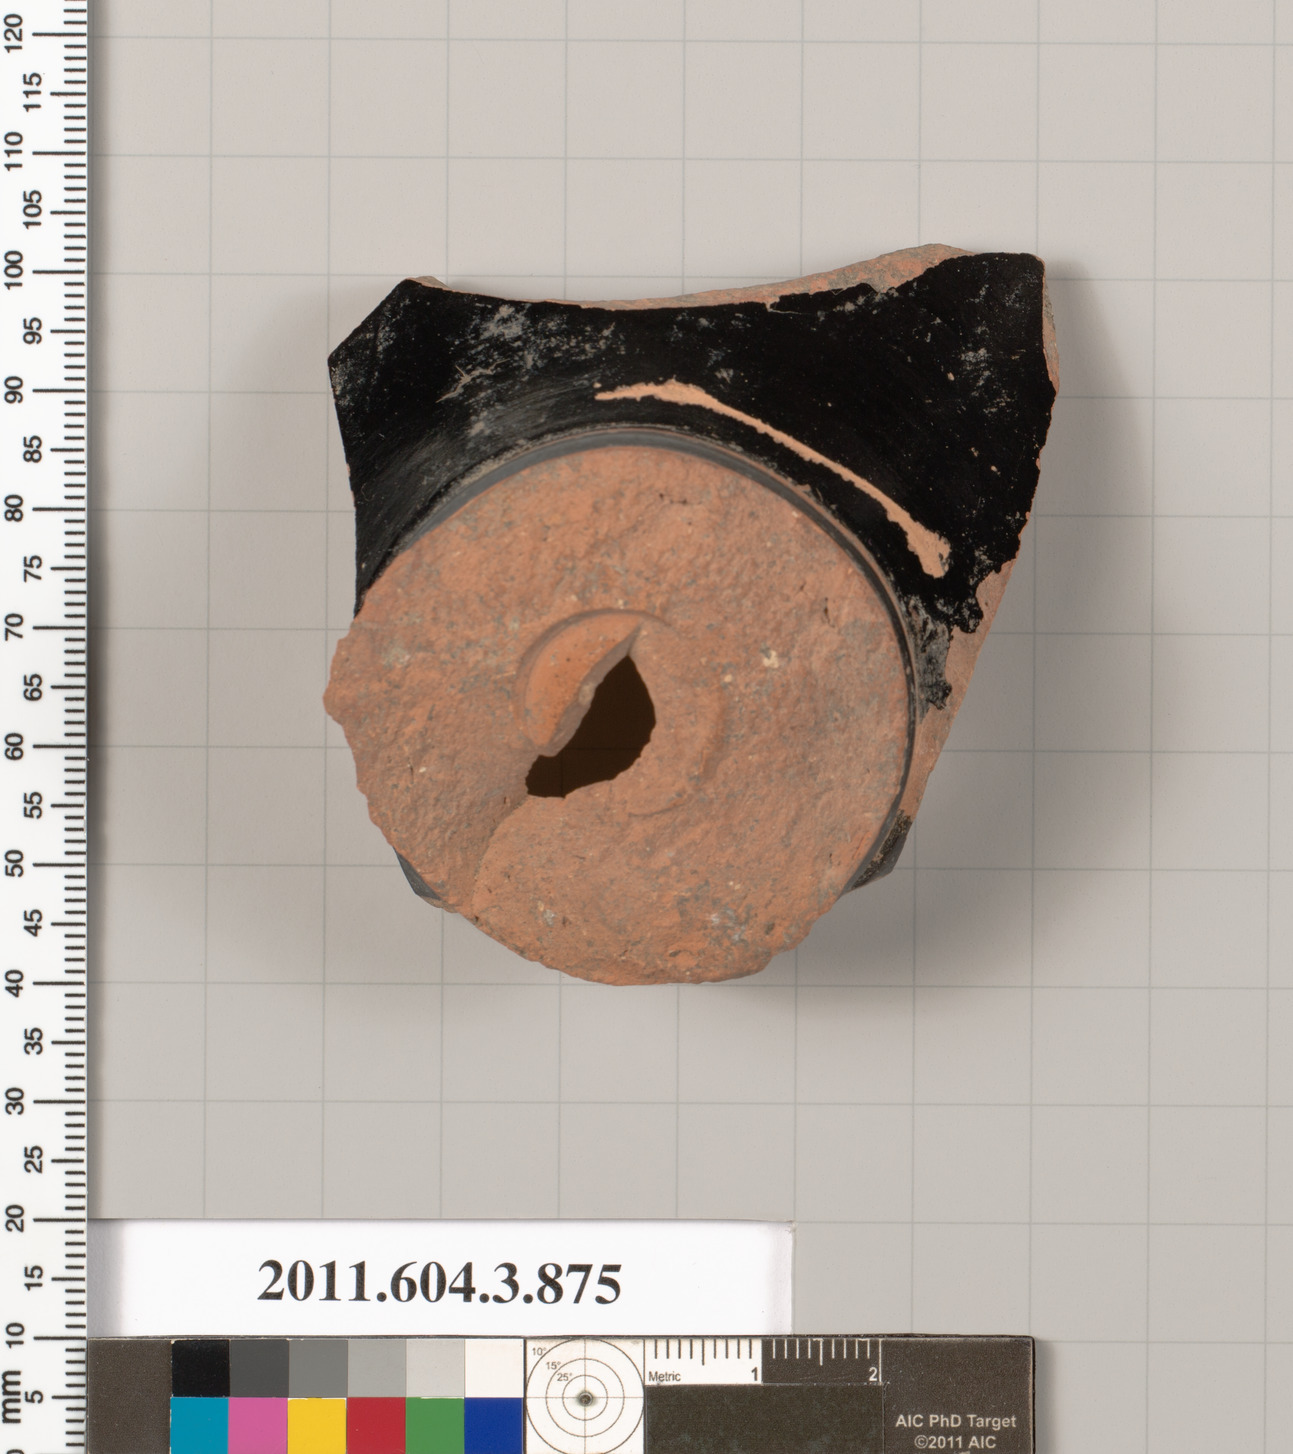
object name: lekythos fragment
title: Terracotta fragment of a lekythos (oil flask)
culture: greek, attic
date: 600-401 BCE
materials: terracotta